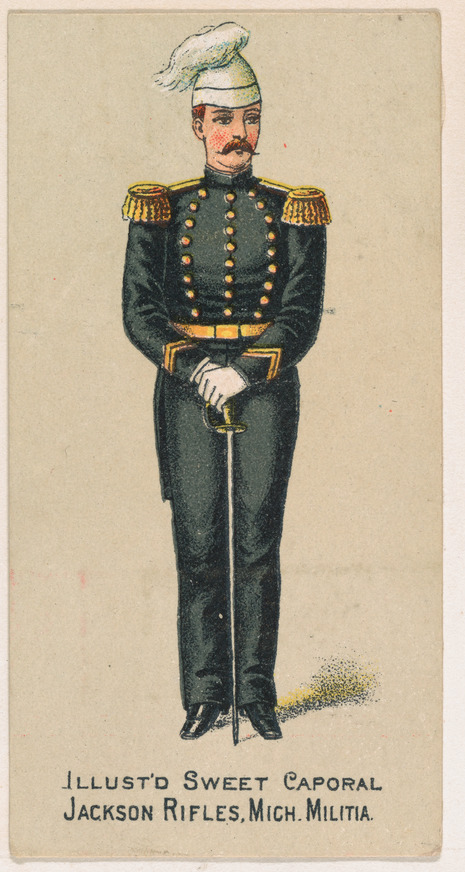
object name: print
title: Jackson Rifles, Michigan Militia, from the Military Series (N224) issued by Kinney Tobacco Company to promote Sweet Caporal Cigarettes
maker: kinney brothers tobacco company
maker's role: publisher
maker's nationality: american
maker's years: 1869-2011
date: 1888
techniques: color lithograph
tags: military,men